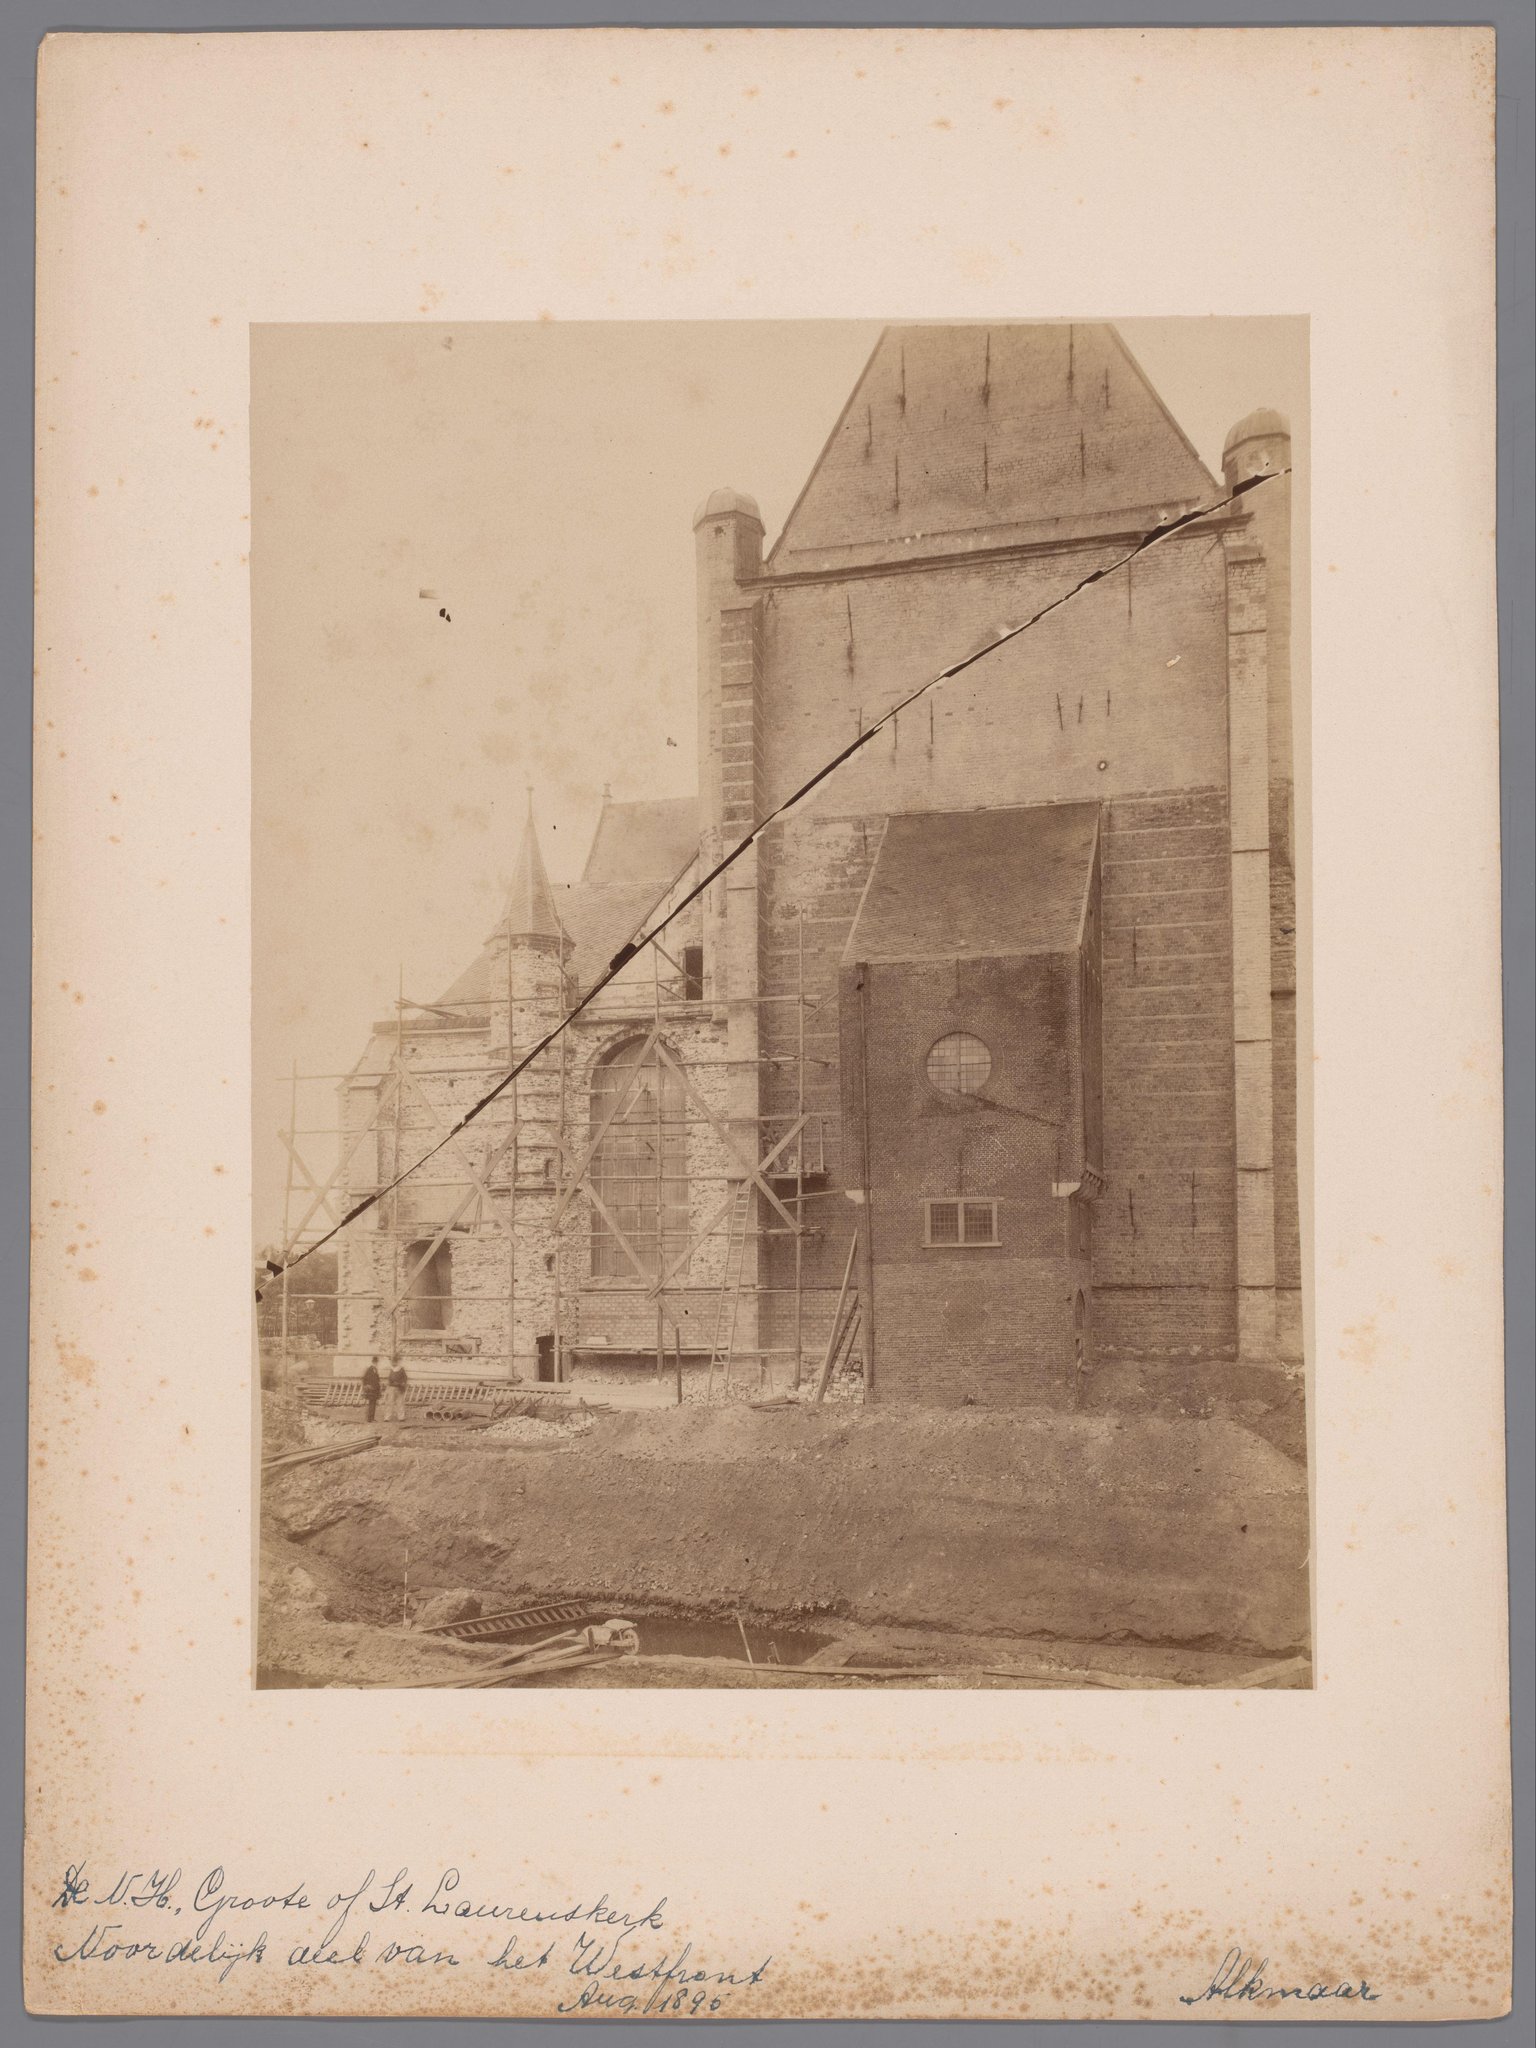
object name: photograph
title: Gedeelte van de Grote of Sint-Laurenskerk te Alkmaar tijdens het afgraven in 1895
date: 1895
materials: cardboard, photographic support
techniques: albumen print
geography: alkmaar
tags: church (exterior), excavation ~ archaeology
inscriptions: annotation: ‘Alkmaar (N.H.)/ Kerk v/d NH gemeente/ Noordelijk deel v/h Westfront/ Aug 1895’, annotation: ‘De N.H., Groote of St. Laurenskerk/ Noordelijk deel van het Westfront 1895/ Alkmaar’